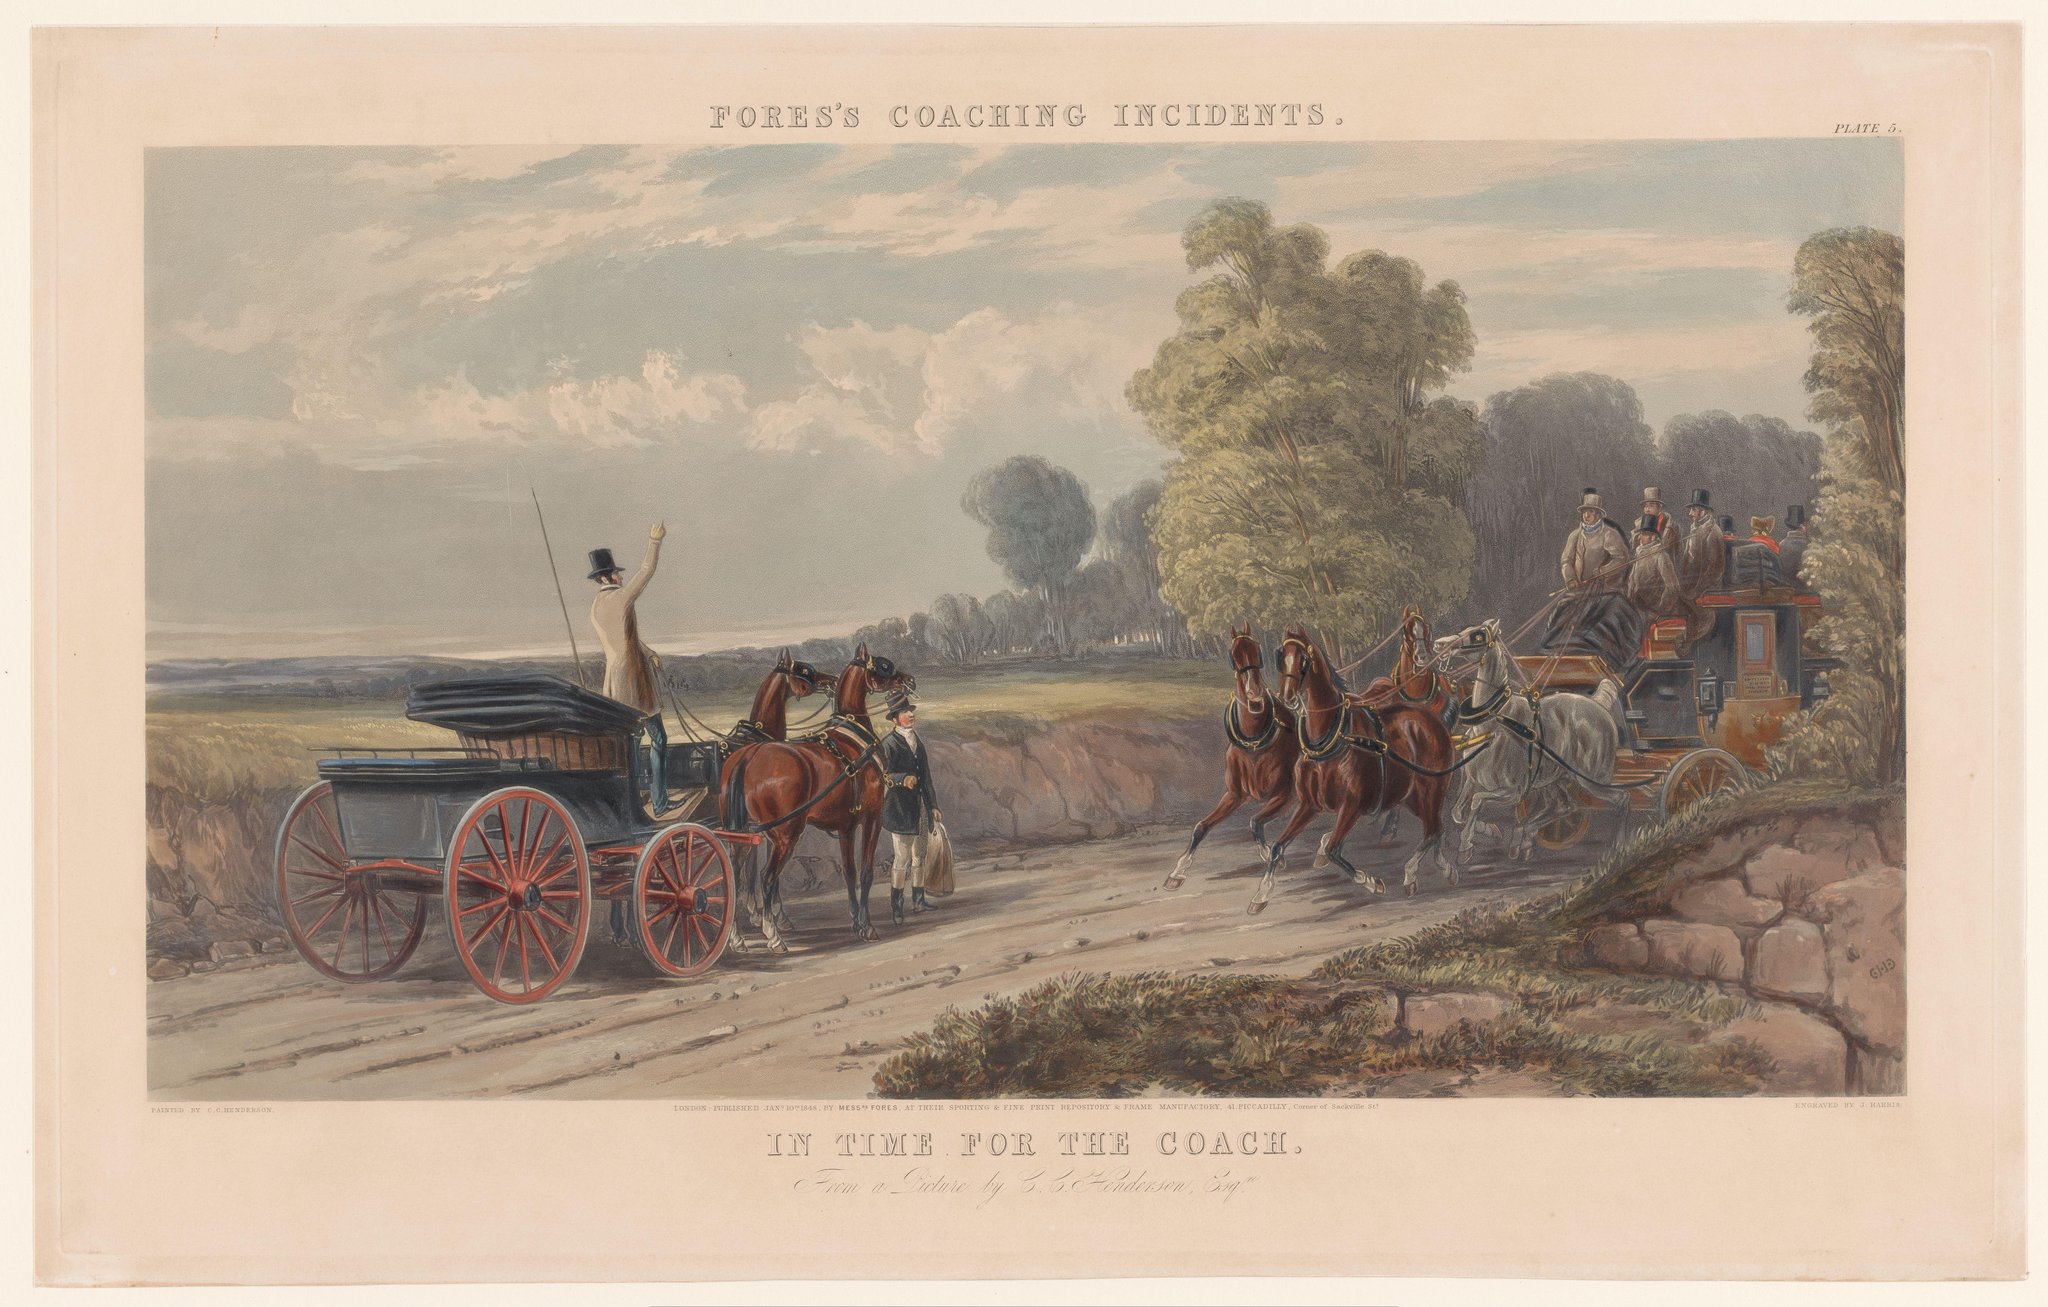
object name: print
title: Twee koetsen op een landweg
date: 1838-1883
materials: paper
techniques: aquatint, etching, hand coloring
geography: london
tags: bus, coach, forest path or lane, four-wheeled vehicle drawn by more than three animals